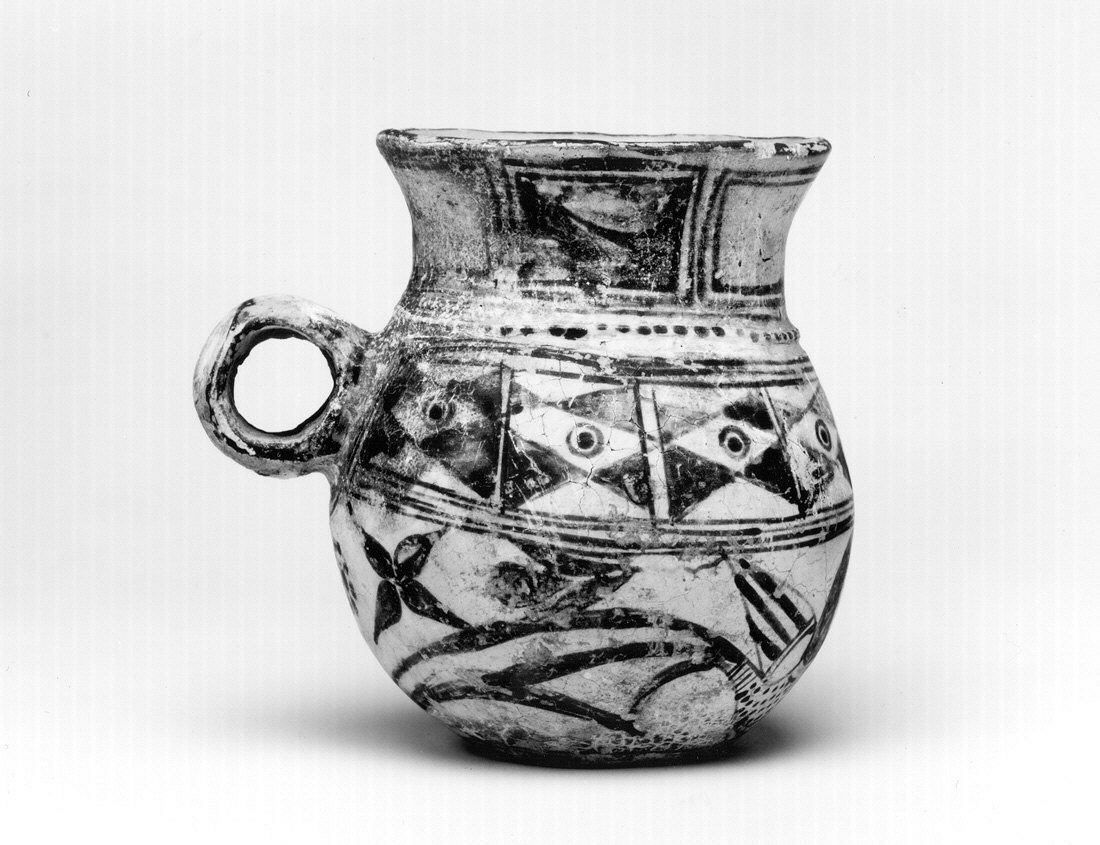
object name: vessel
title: Vessel decorated with birds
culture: western central asian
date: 701-900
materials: ceramic, paint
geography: western central asia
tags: birds